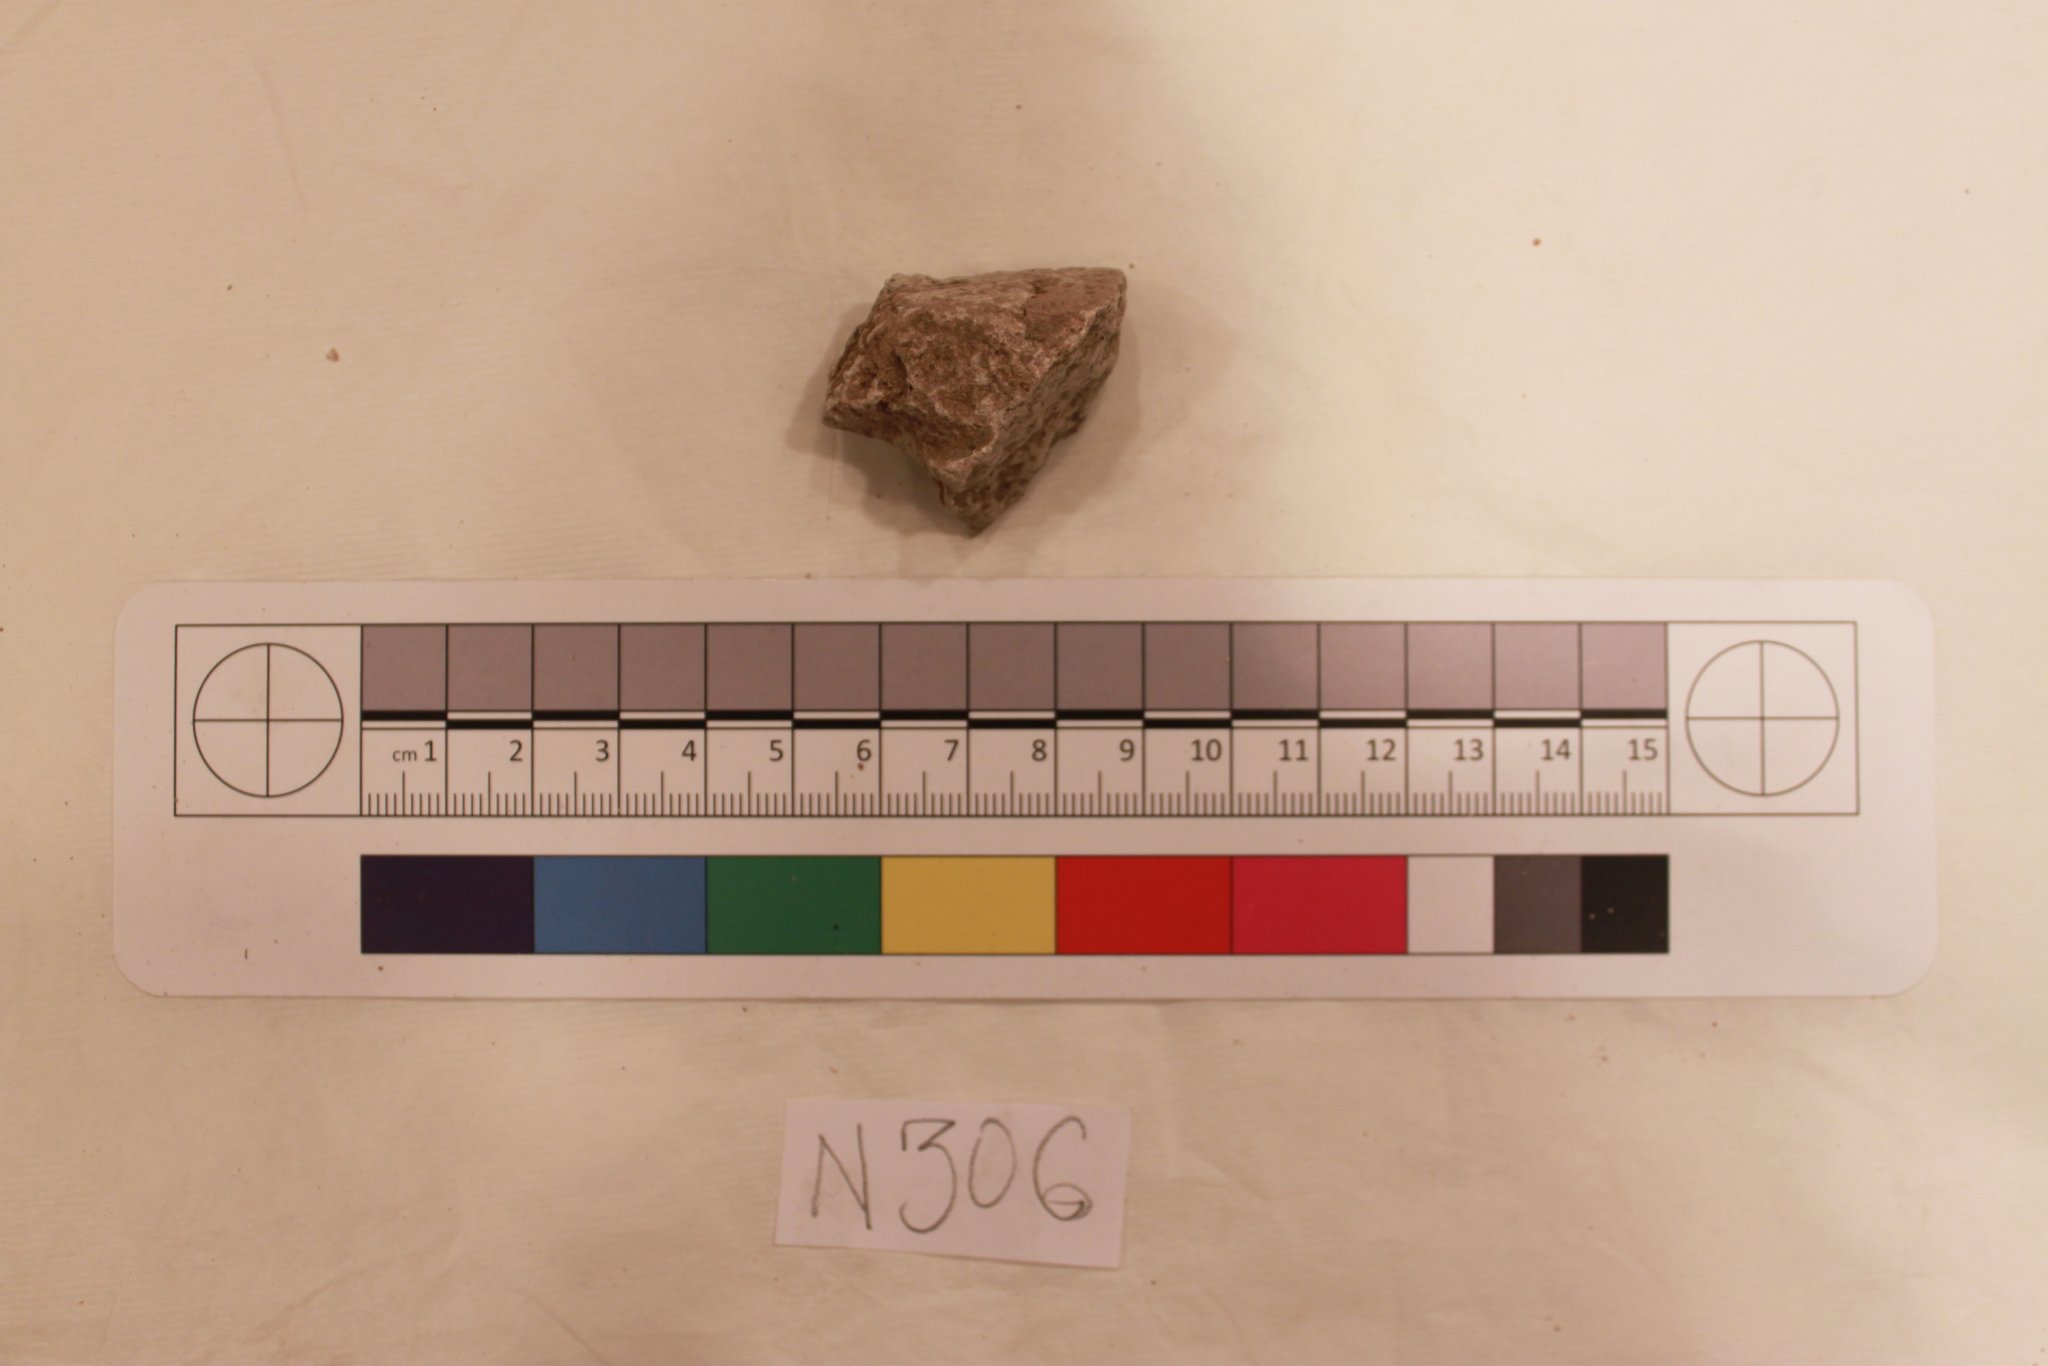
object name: fragment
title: Stucco Fragment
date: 701-1200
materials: plaster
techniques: carving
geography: iran